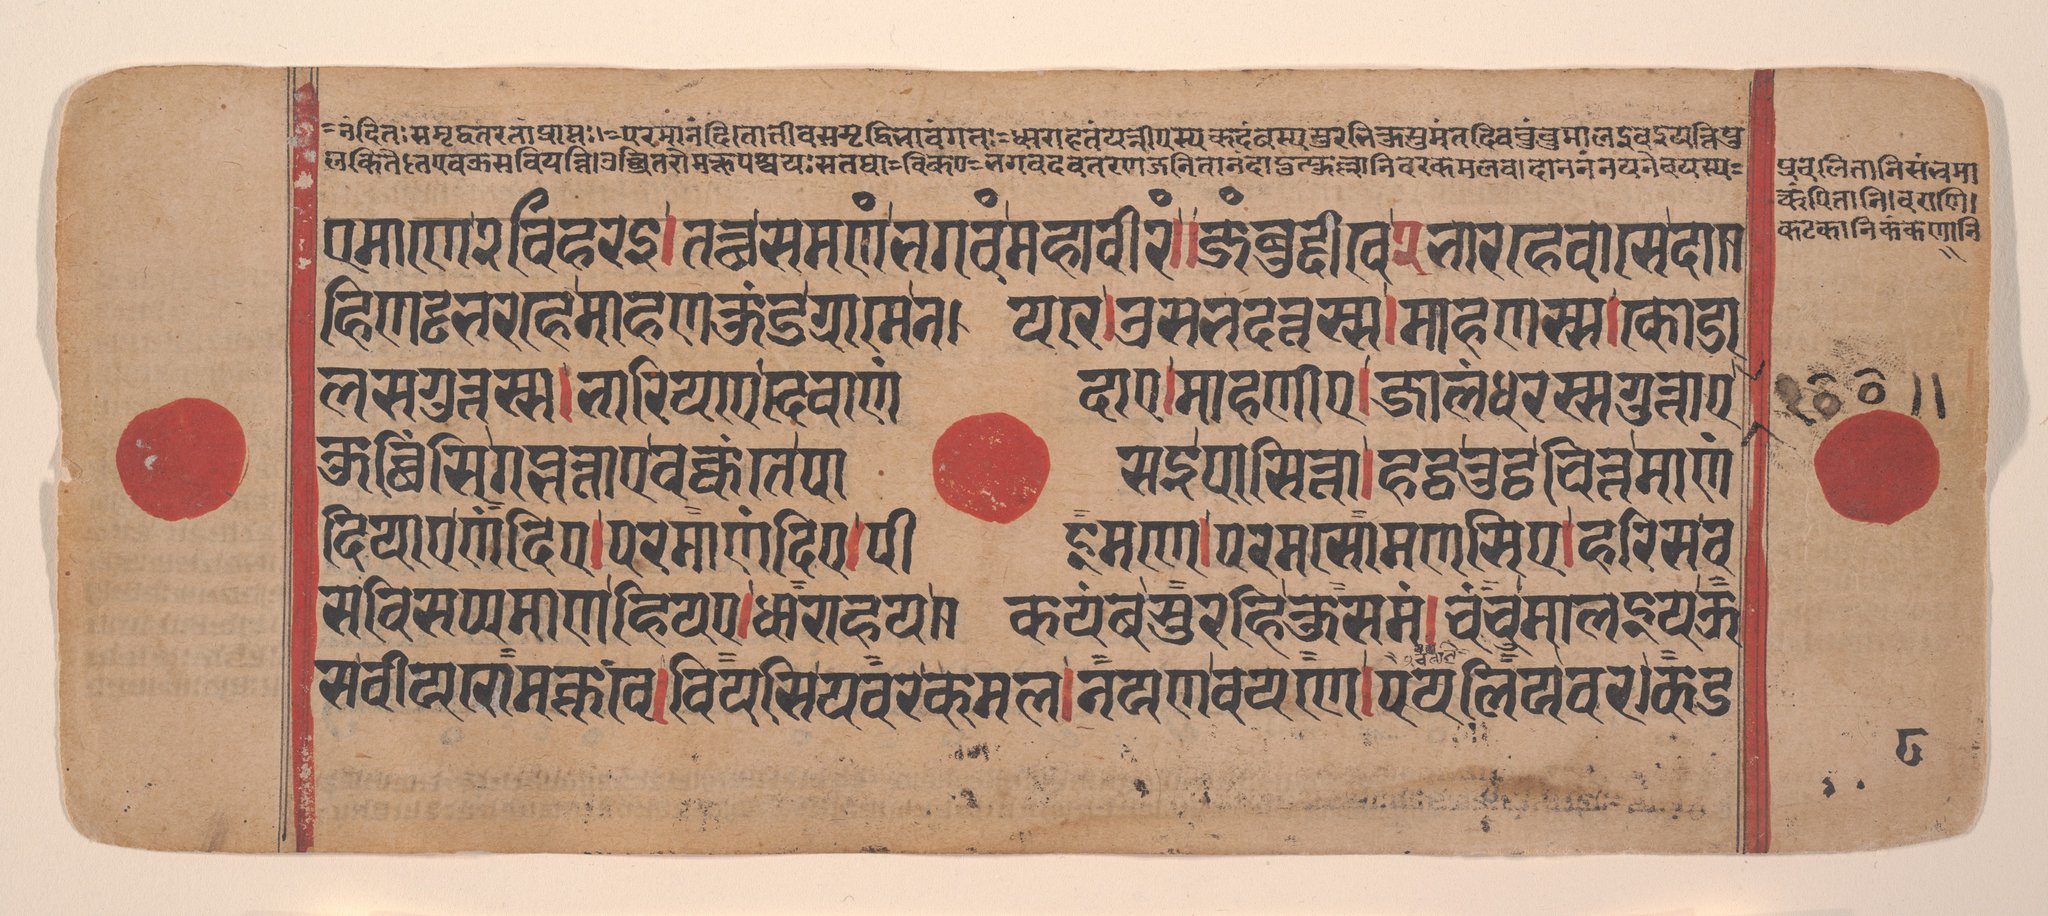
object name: folio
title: Page from a Dispersed Kalpa Sutra (Jain Book of Rituals)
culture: indian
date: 1401-1500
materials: gold, ink, paper, watercolor